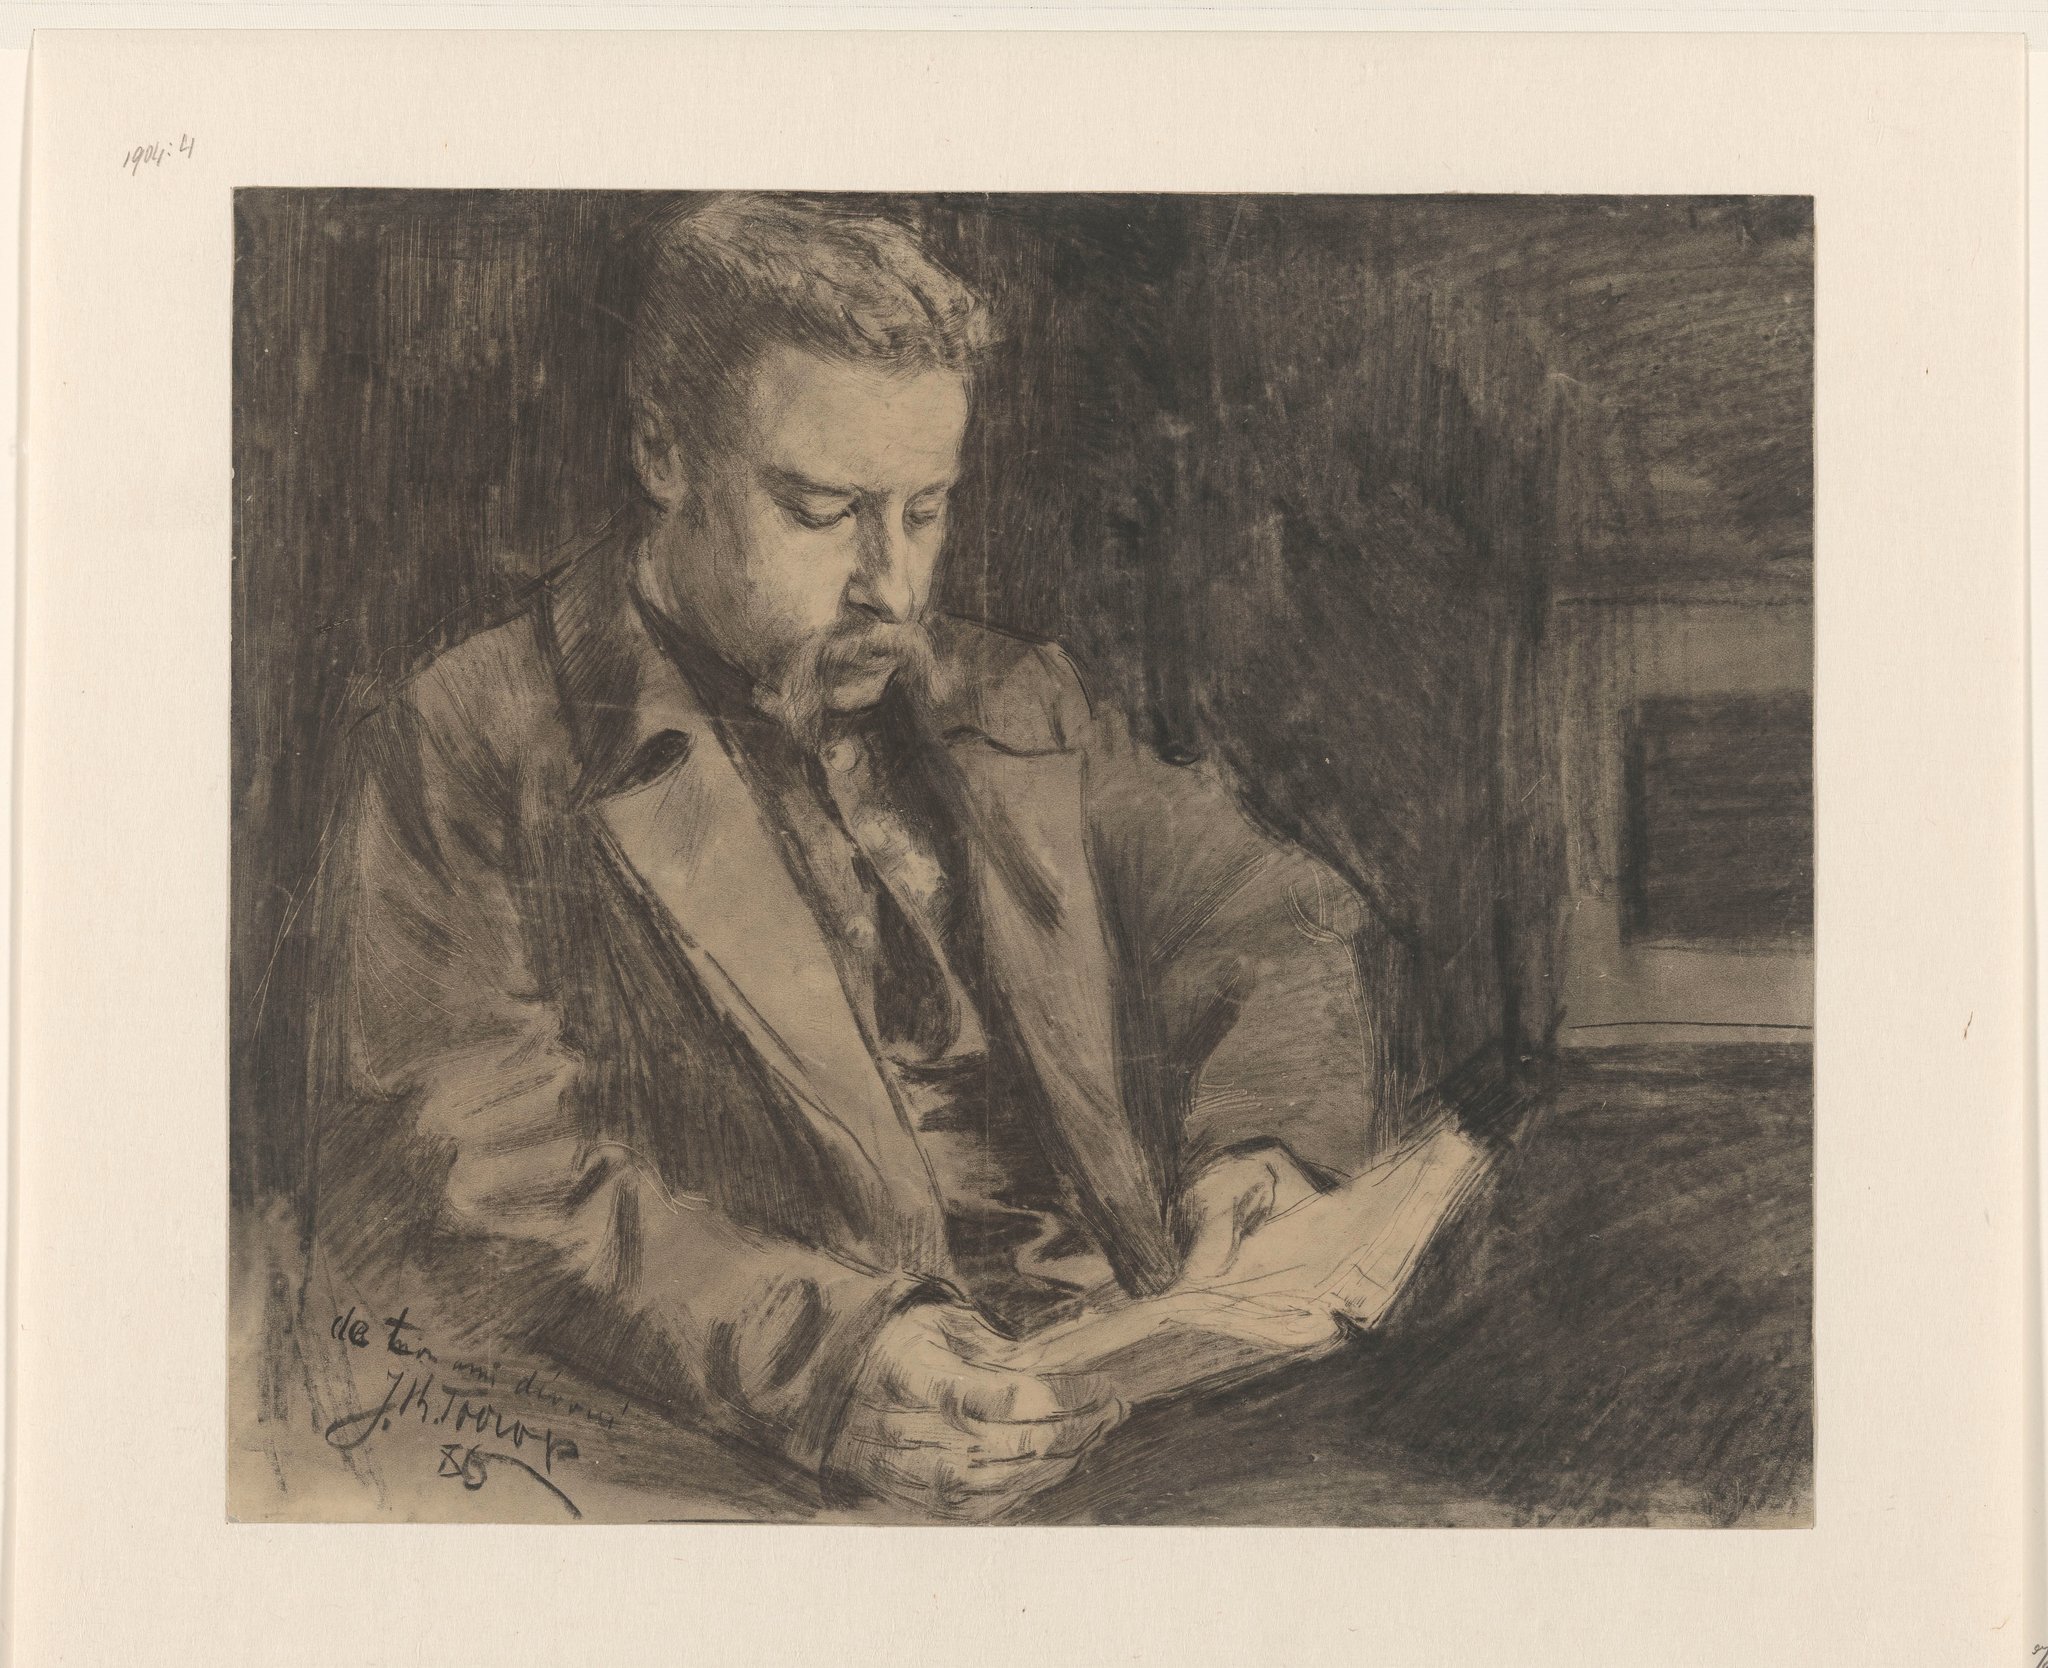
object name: drawing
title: Portret van Engelbert van Bevervoorde, slotvoogd van Muiden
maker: jan toorop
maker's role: draughtsman, painter, print maker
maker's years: 1858-1928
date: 1886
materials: chalk, paper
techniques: scratching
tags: historical persons